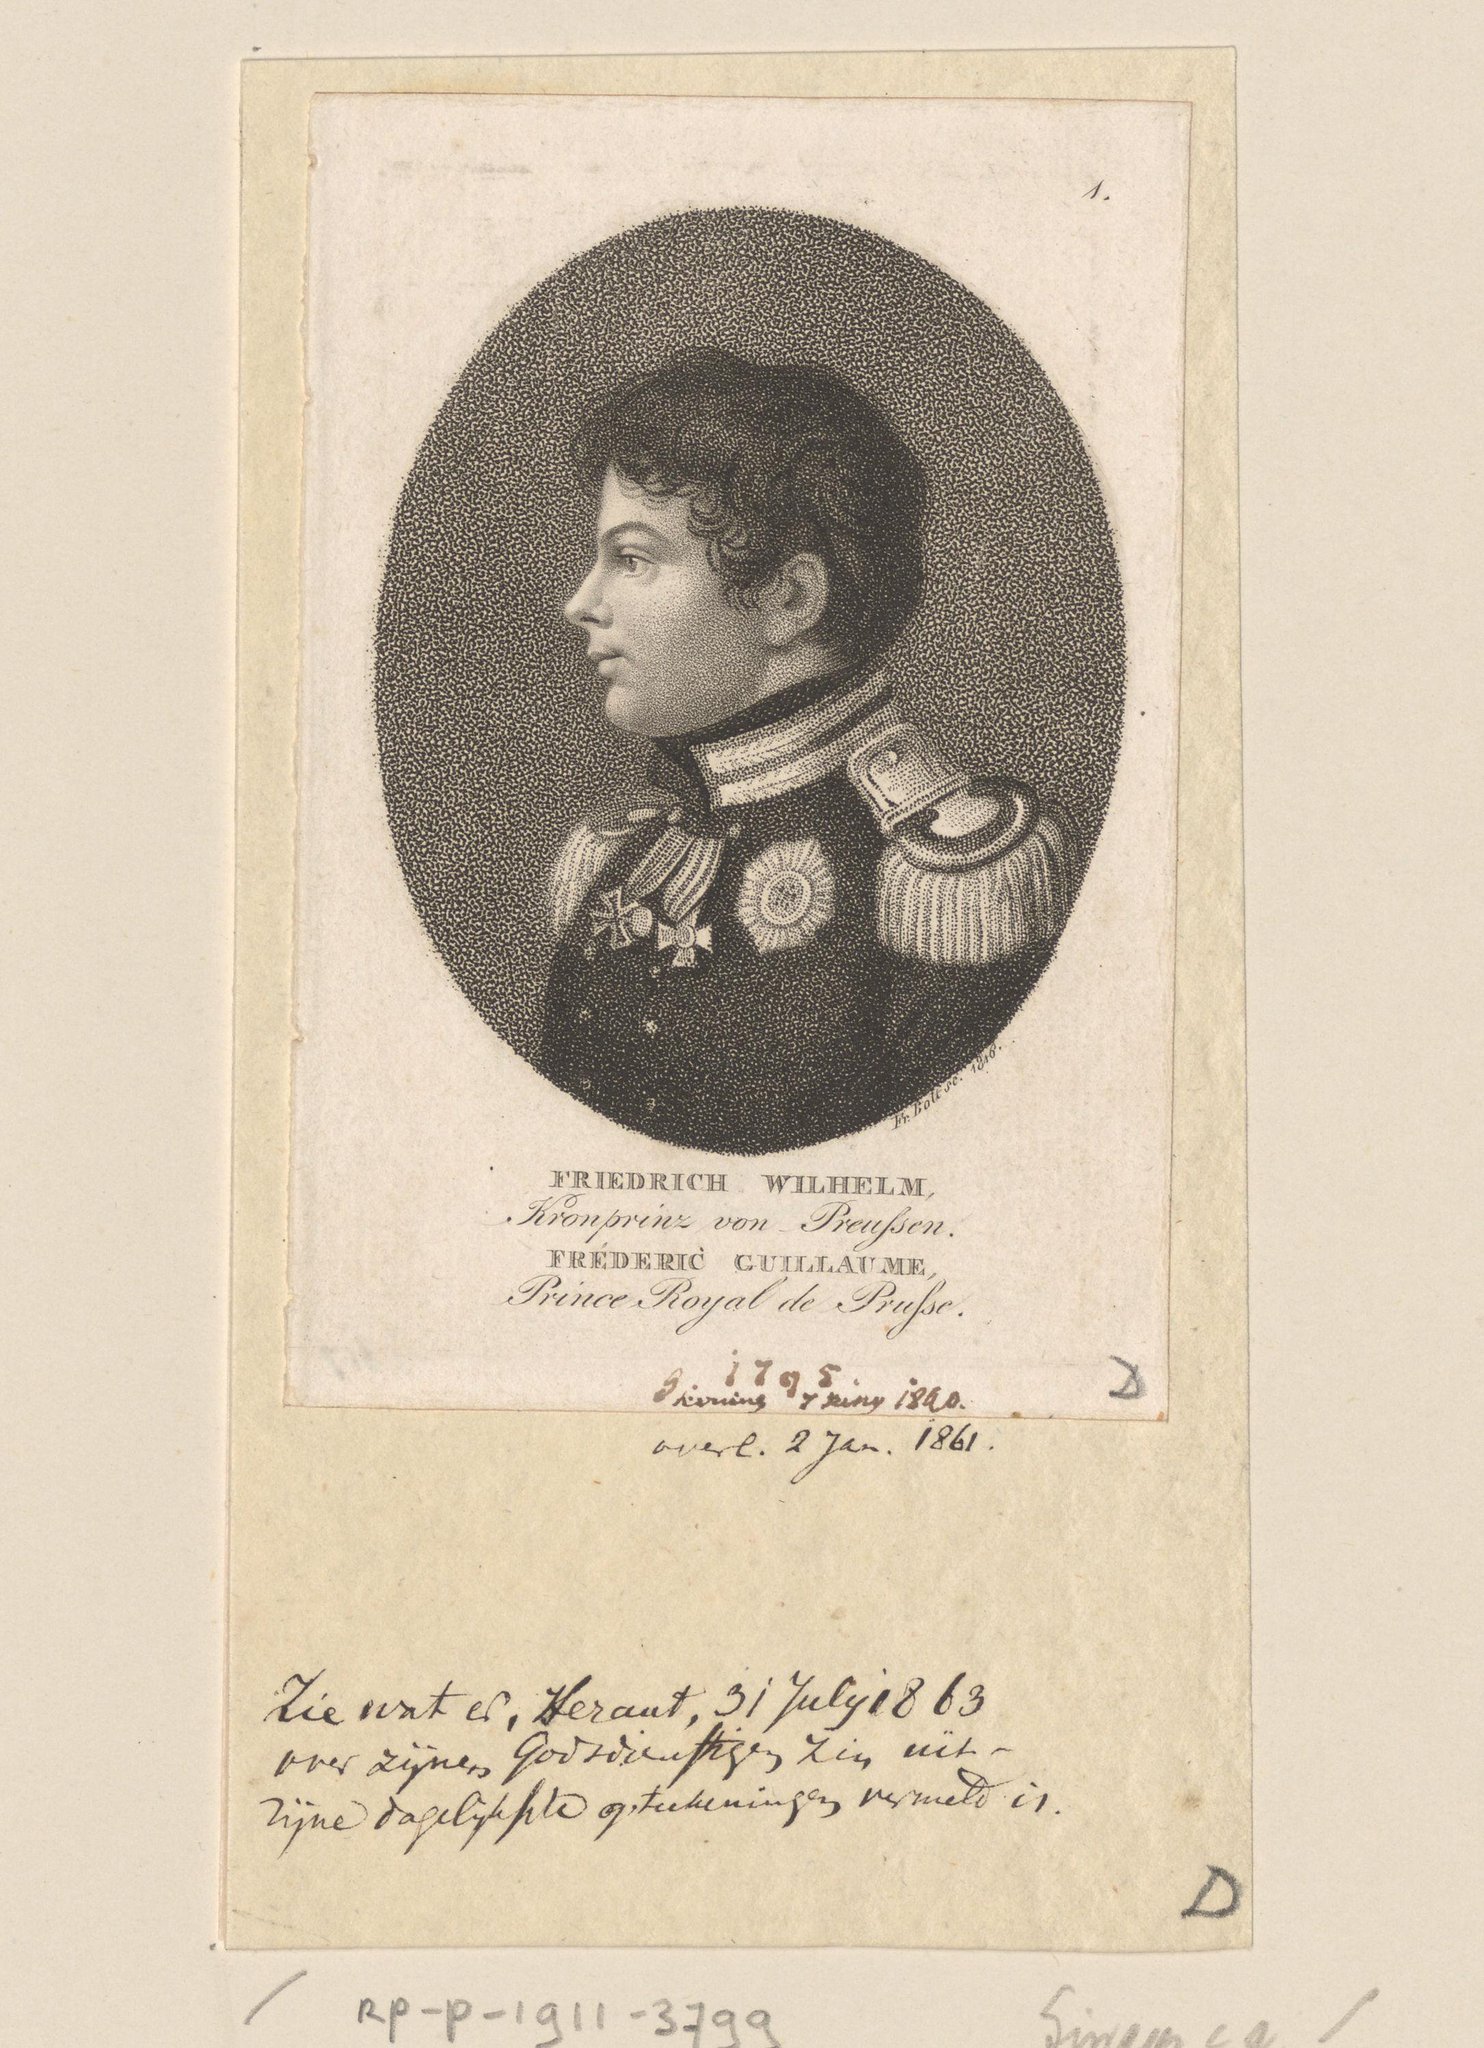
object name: print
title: Portret van Frederik Willem IV als kroonprins van Pruisen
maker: johann friedrich bolt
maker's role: print maker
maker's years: 1769-1836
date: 1816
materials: paper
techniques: stippling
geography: berlin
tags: berlin, frederik willem iv (koning van pruisen), historical persons, (military) uniforms, crown prince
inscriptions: collector's mark: Lugt 2228, inscription: ‘g. 1795/ koning 7 Juny 1840’, inscription: ‘overl. 2 Jan. 1861./ Zie wat er, Heraut, 31 July 1863/ over zijnen Godsdienstige Zin uit/ zijne dagelijkse opteekeningen vermeld is.’